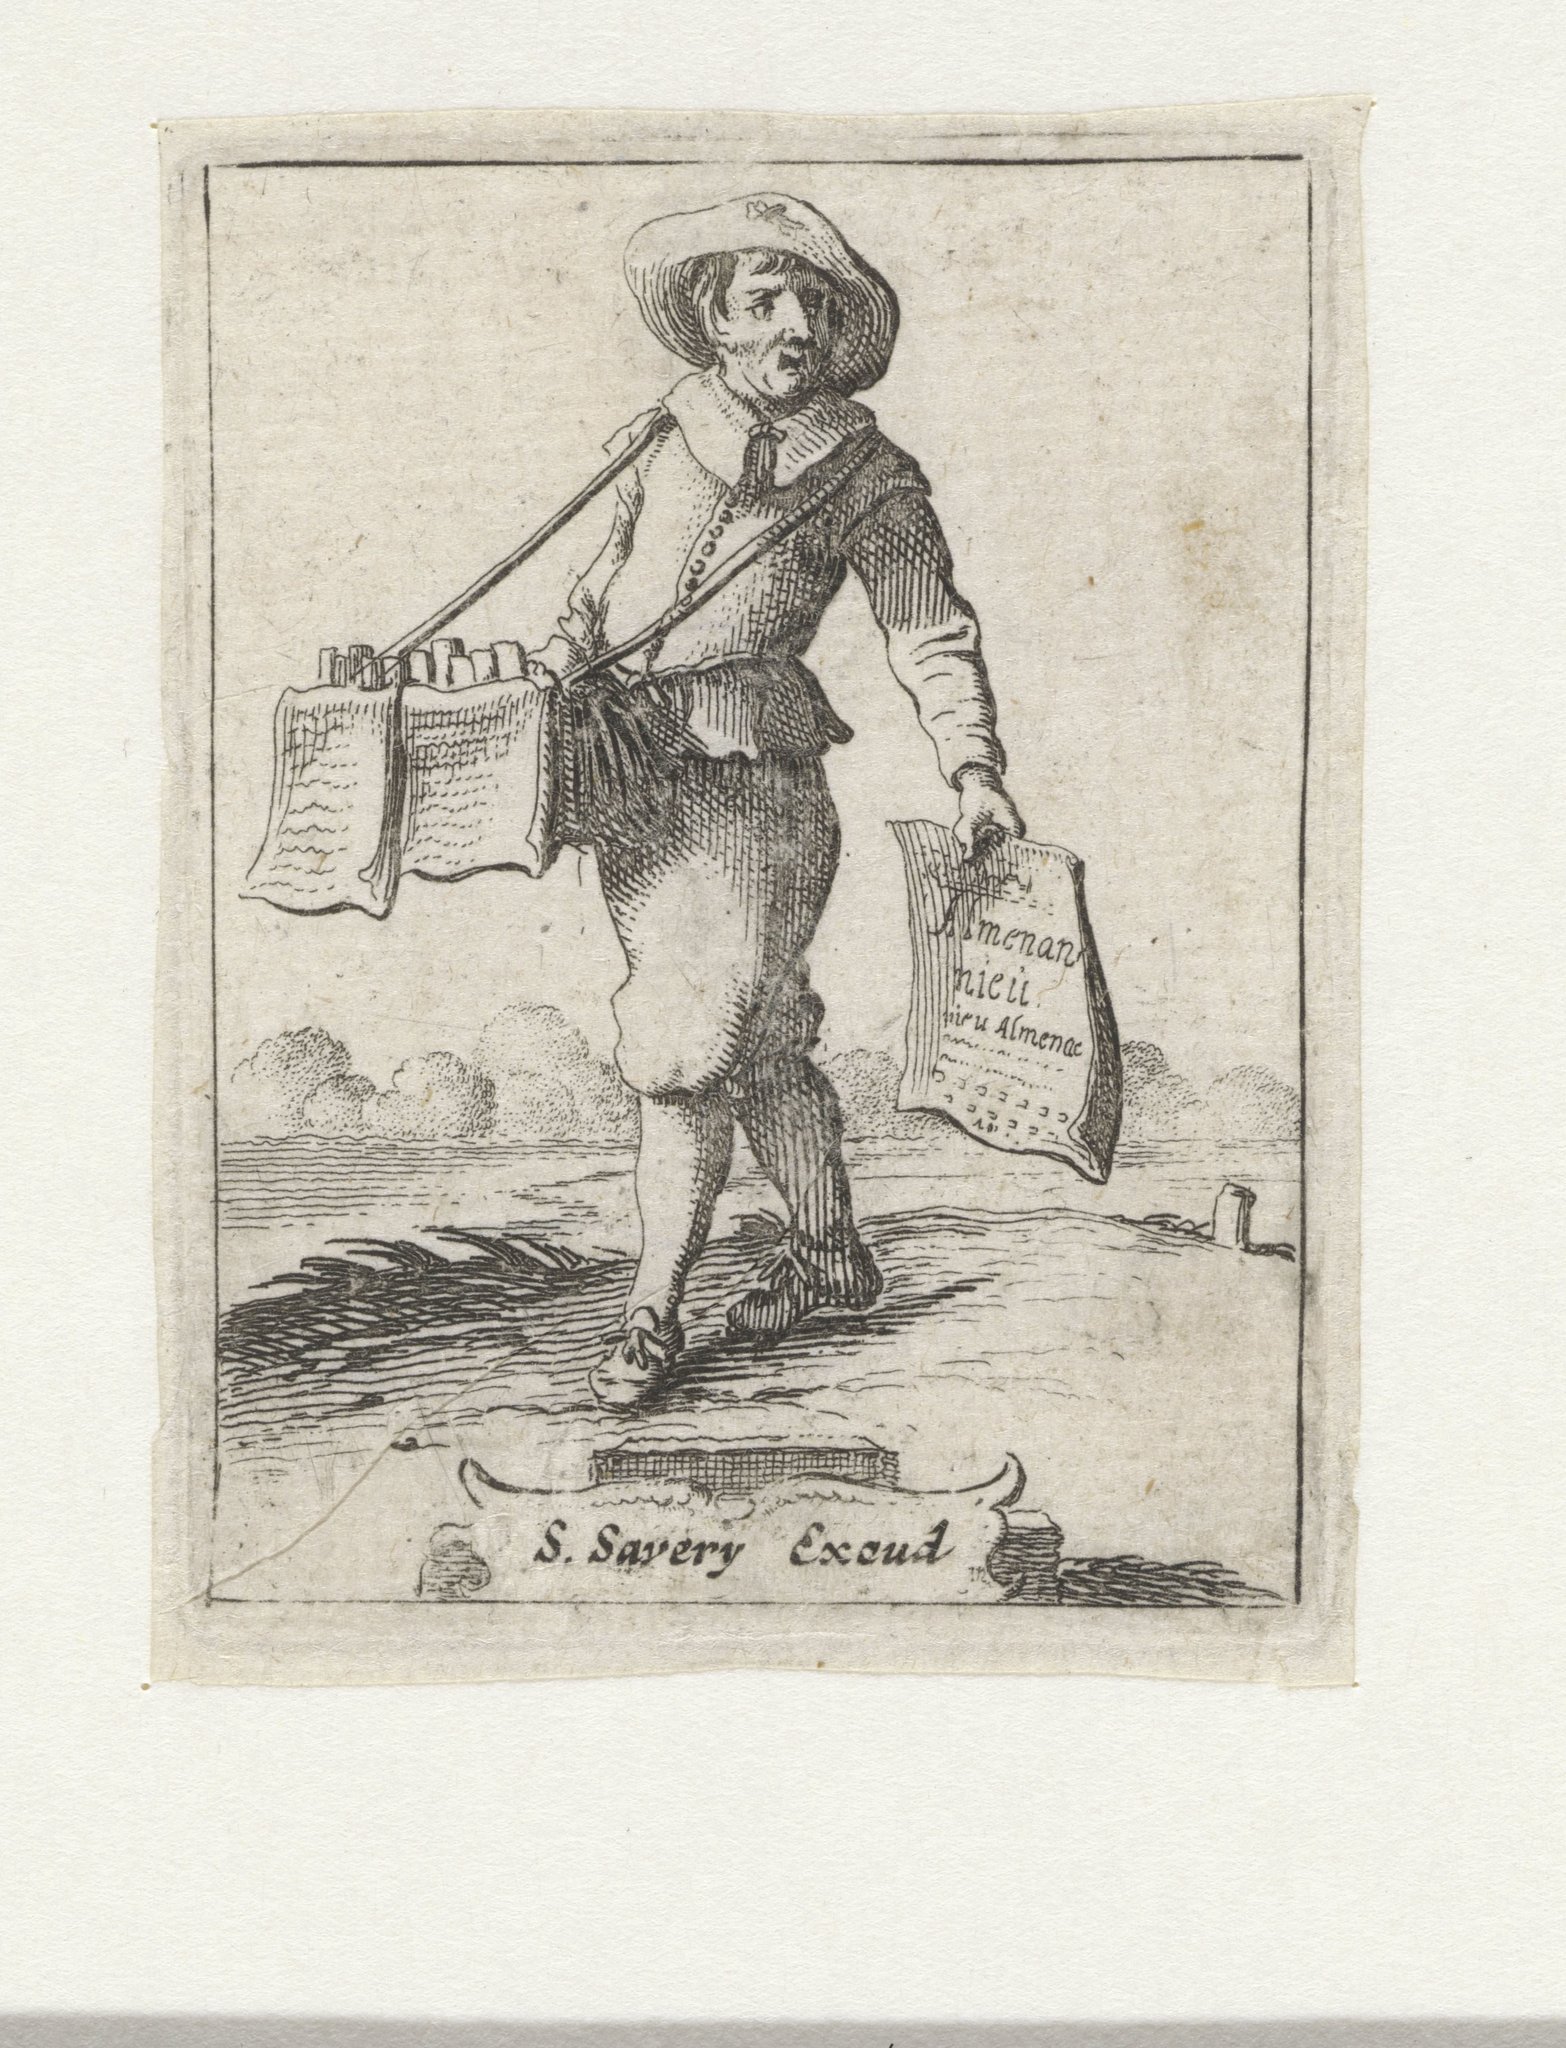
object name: titelprent, frontispice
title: Marskramer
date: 1638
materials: paper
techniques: etching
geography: amsterdam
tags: pedlar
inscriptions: collector's mark: Lugt 2228, collector's mark: Lugt 2760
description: Een venter met om de hals een bak met koopwaar kondigt zijn handelswaar aan. In de hand heeft hij een bundel papier met daarop de tekst: "Almen nieu nieu Almenac." Titelprent van een serie van 32 prenten met genretaferelen.